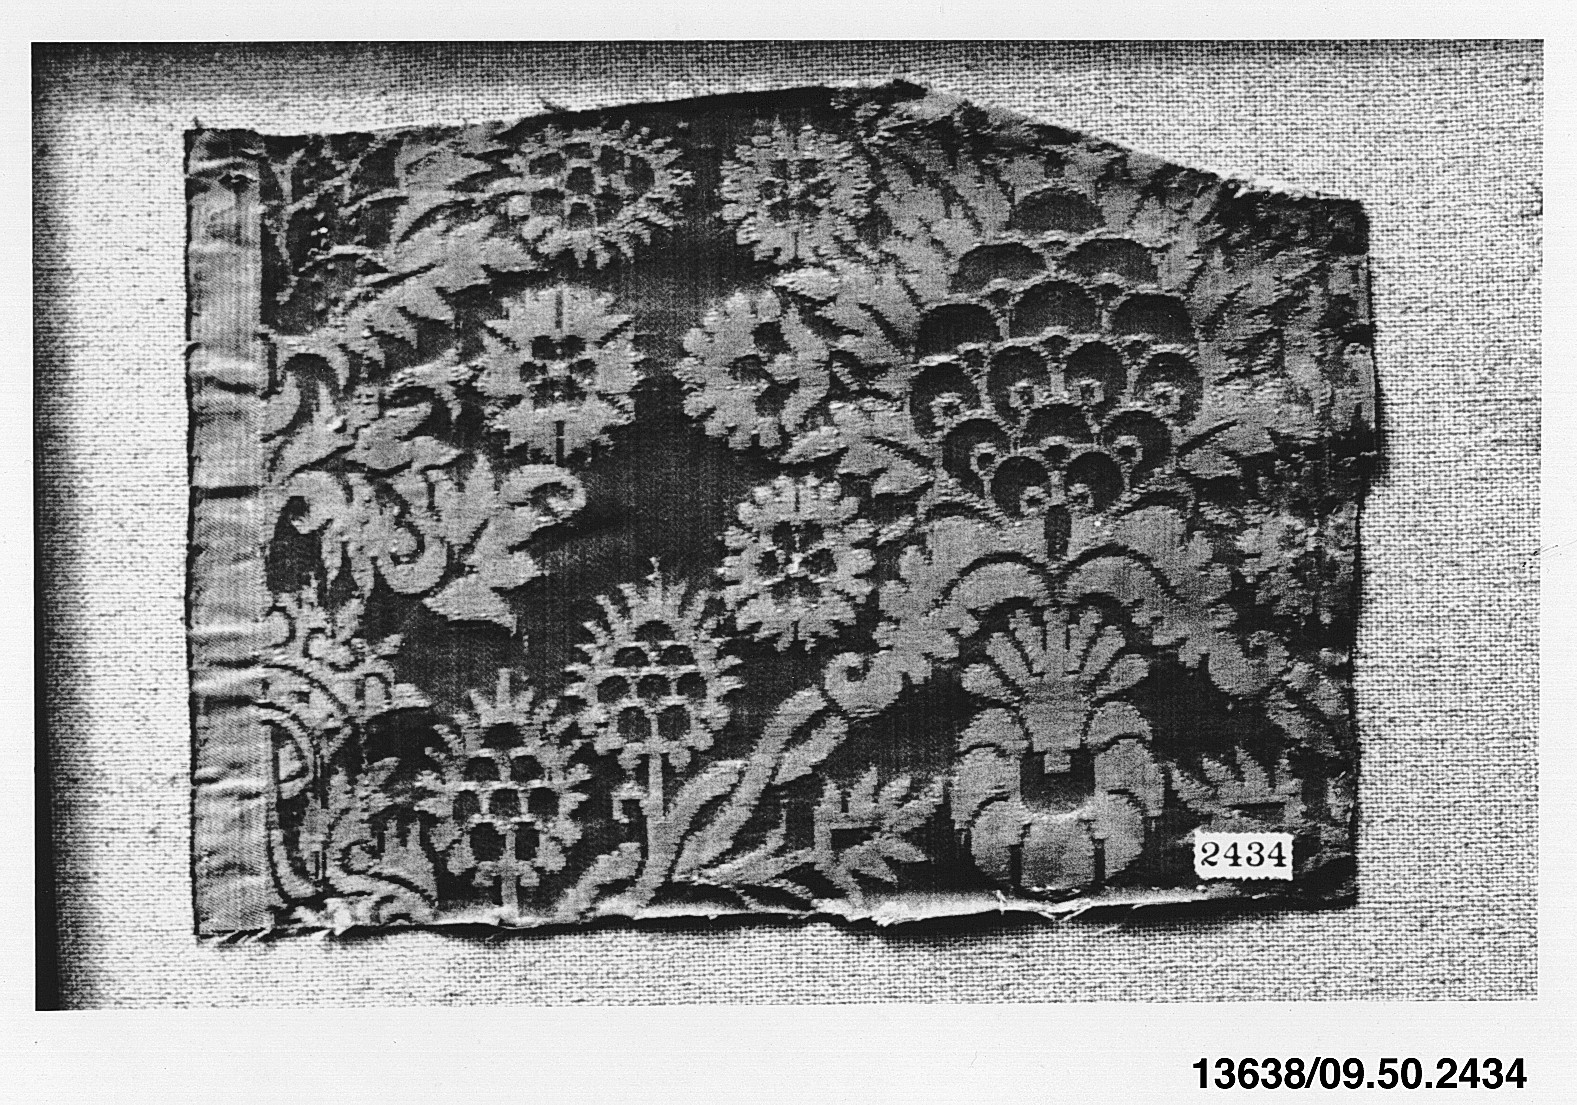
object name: piece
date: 1501-1600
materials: silk